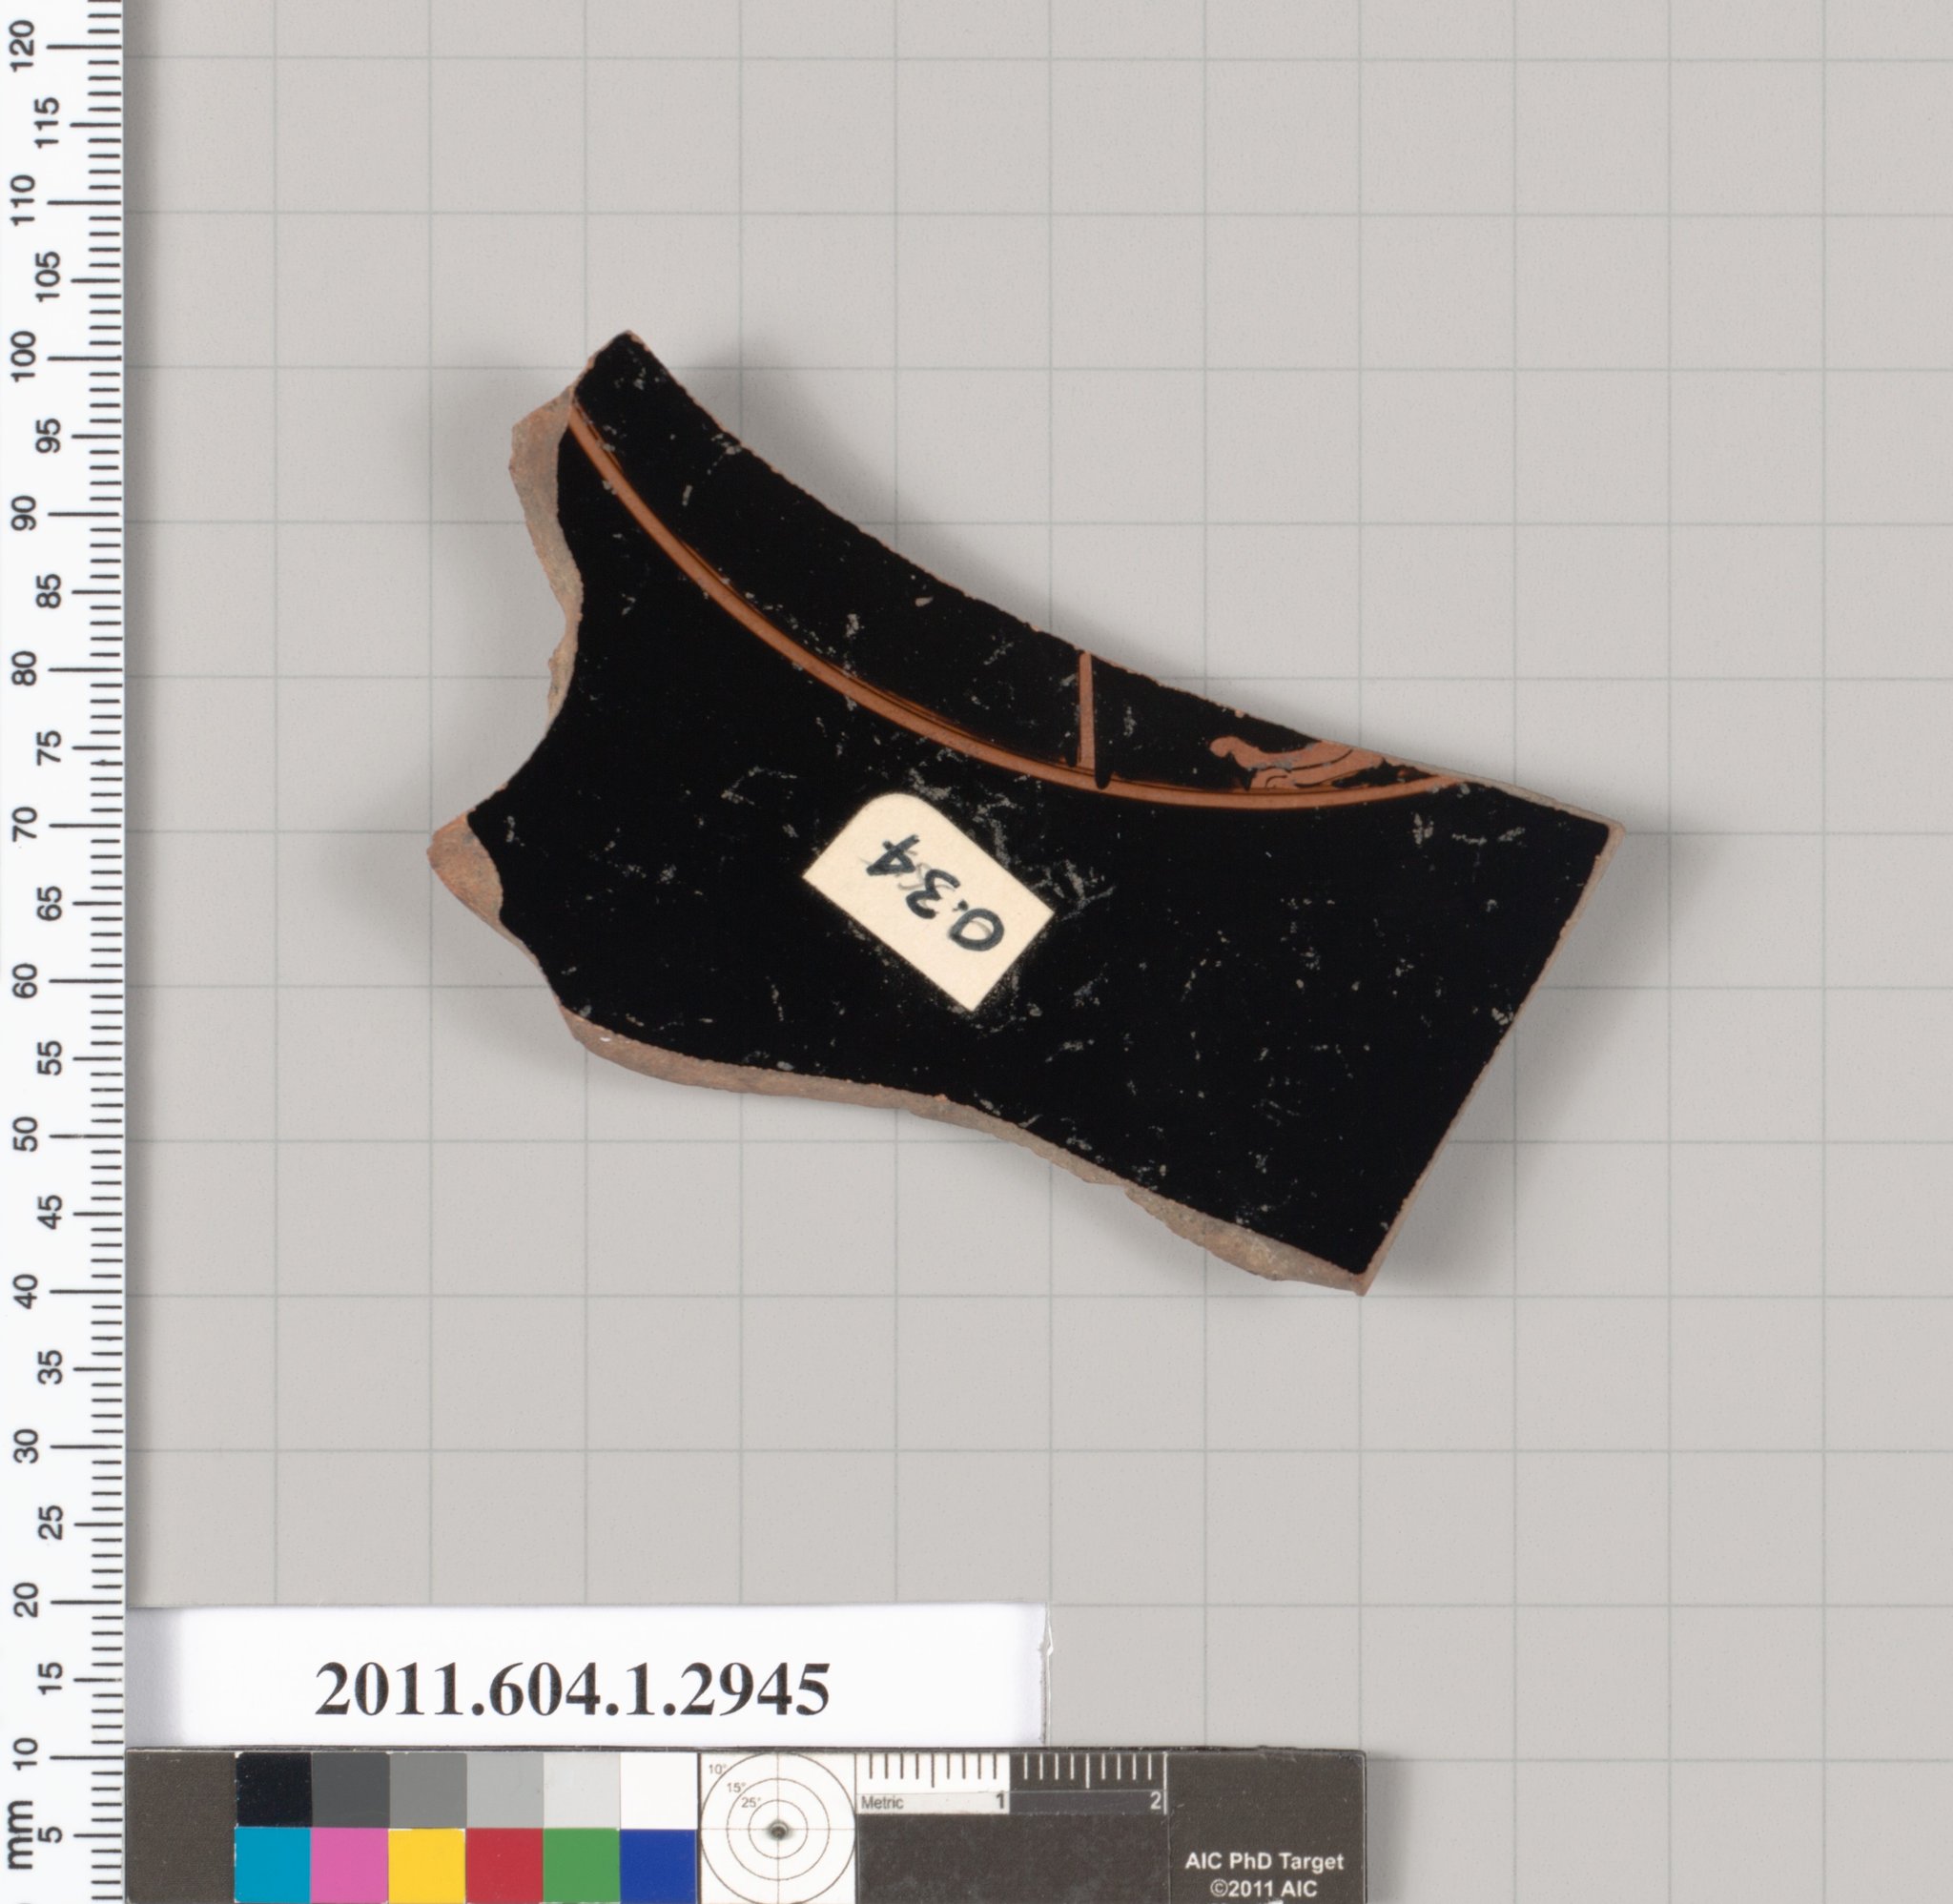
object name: kylix fragment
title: Terracotta fragment of a kylix (drinking cup)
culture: greek, attic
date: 500-490 BCE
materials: terracotta